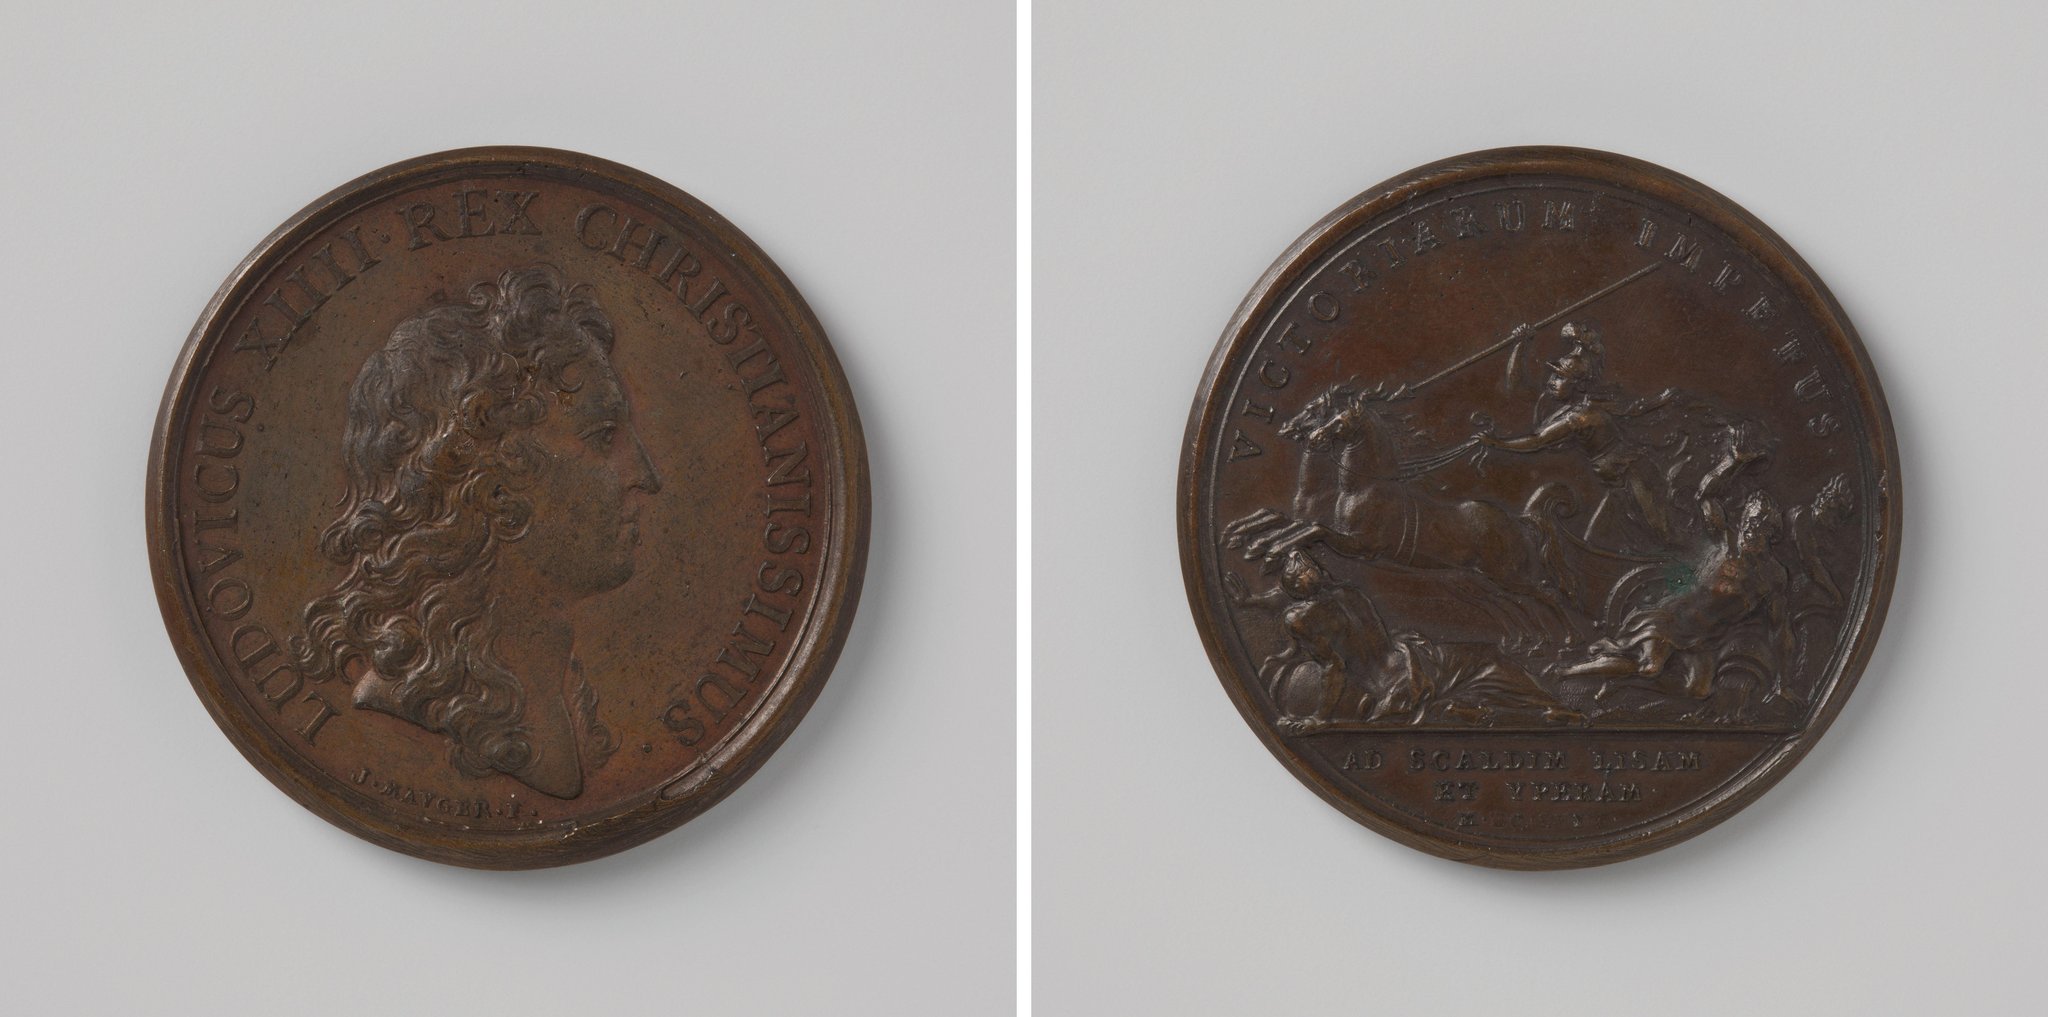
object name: history medal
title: Overwinningen aan de Schelde, Leie en Ieper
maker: jean mauger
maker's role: medailleur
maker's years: 1648-1722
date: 1699-1703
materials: bronze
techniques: striking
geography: paris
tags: lodewijk xiv (koning van frankrijk)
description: Bronzen penning. Voorzijde: borststuk jongeman (Lodewijk XIV) binnen omschrift. Keerzijde: Bellona, godin van de oorlog rijdt op zegewagen tussen drie verbaasde riviergoden door binnen omschrift; afsnede: opschrift